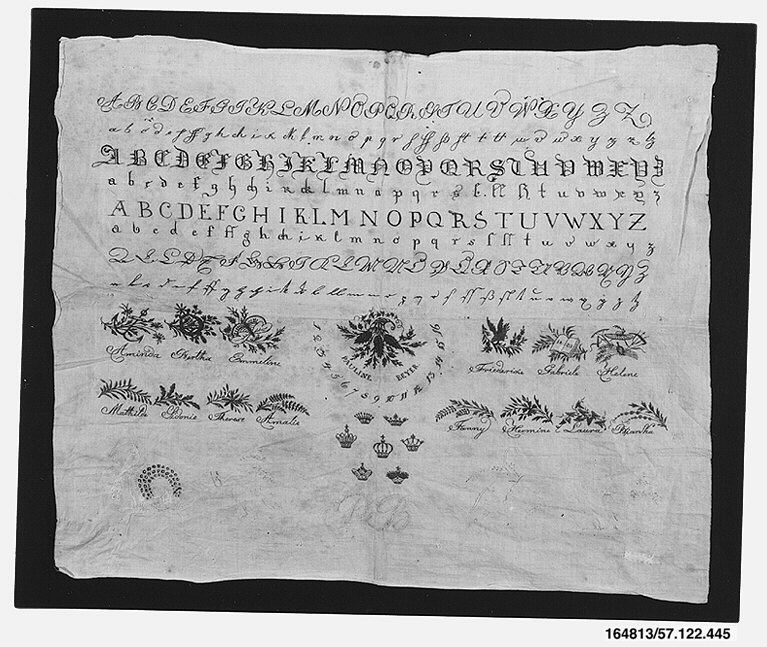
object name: sampler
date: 1833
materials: cotton, linen